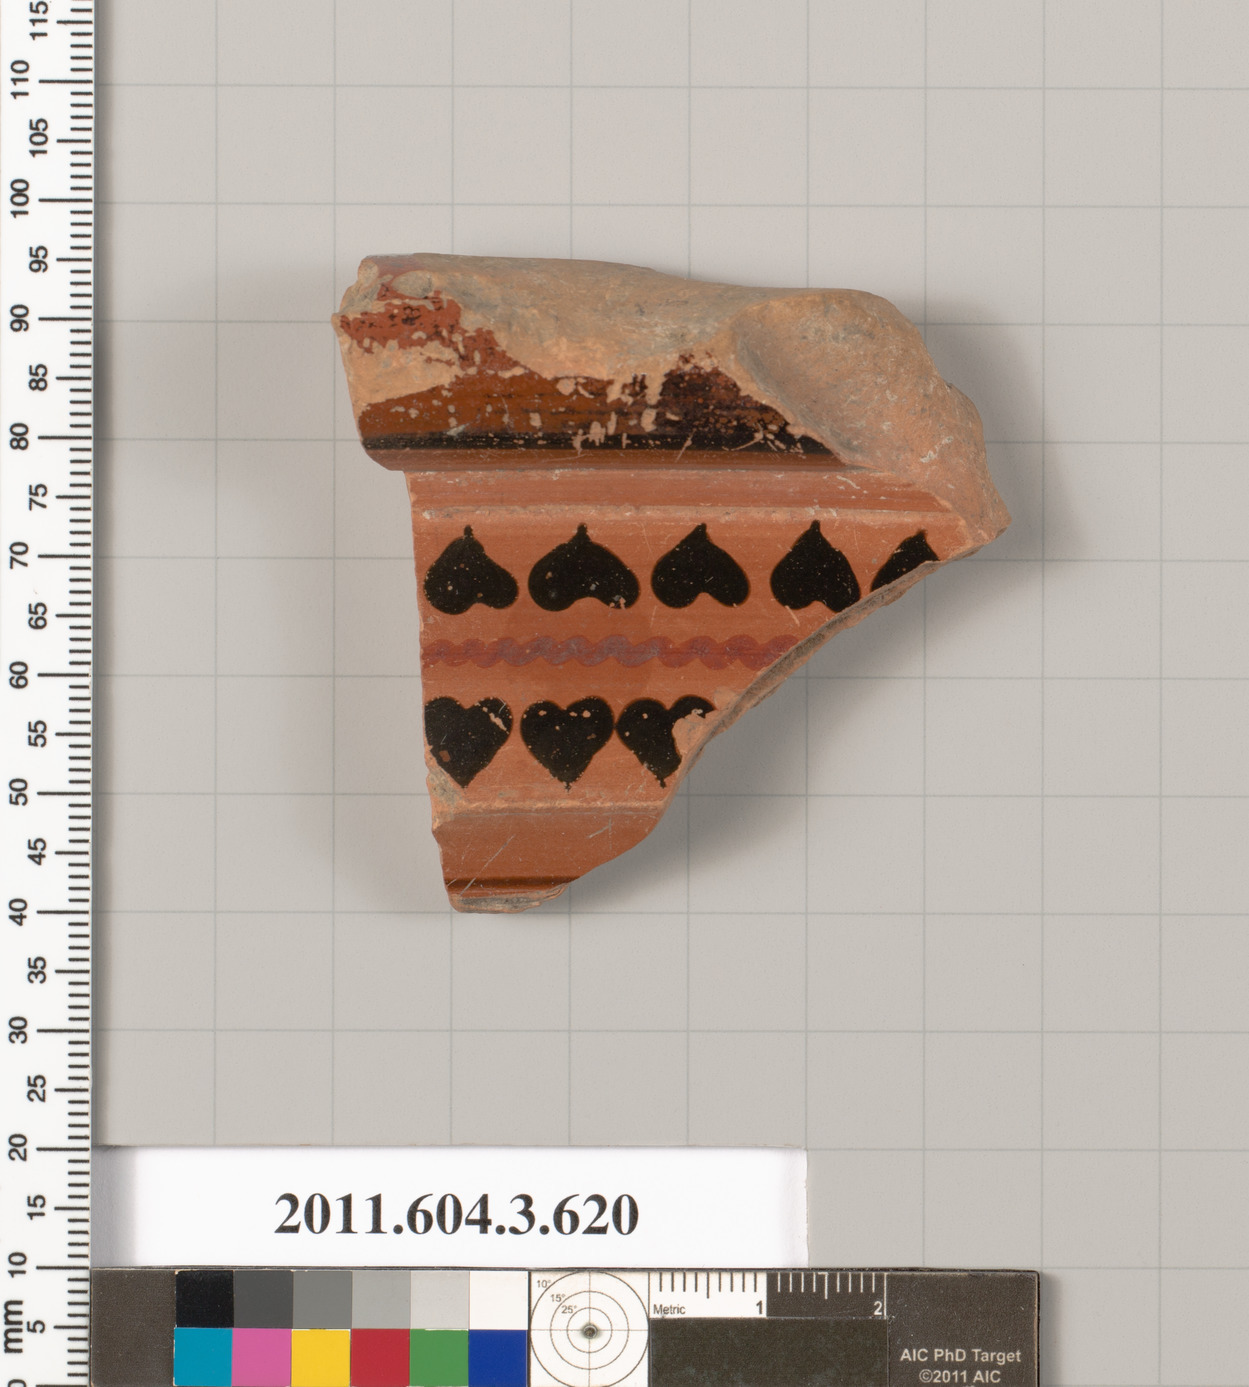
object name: calyx krater fragment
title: Terracotta fragment of a calyx-krater (bowl for mixing wine and water)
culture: greek, attic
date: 550-526 BCE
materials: terracotta